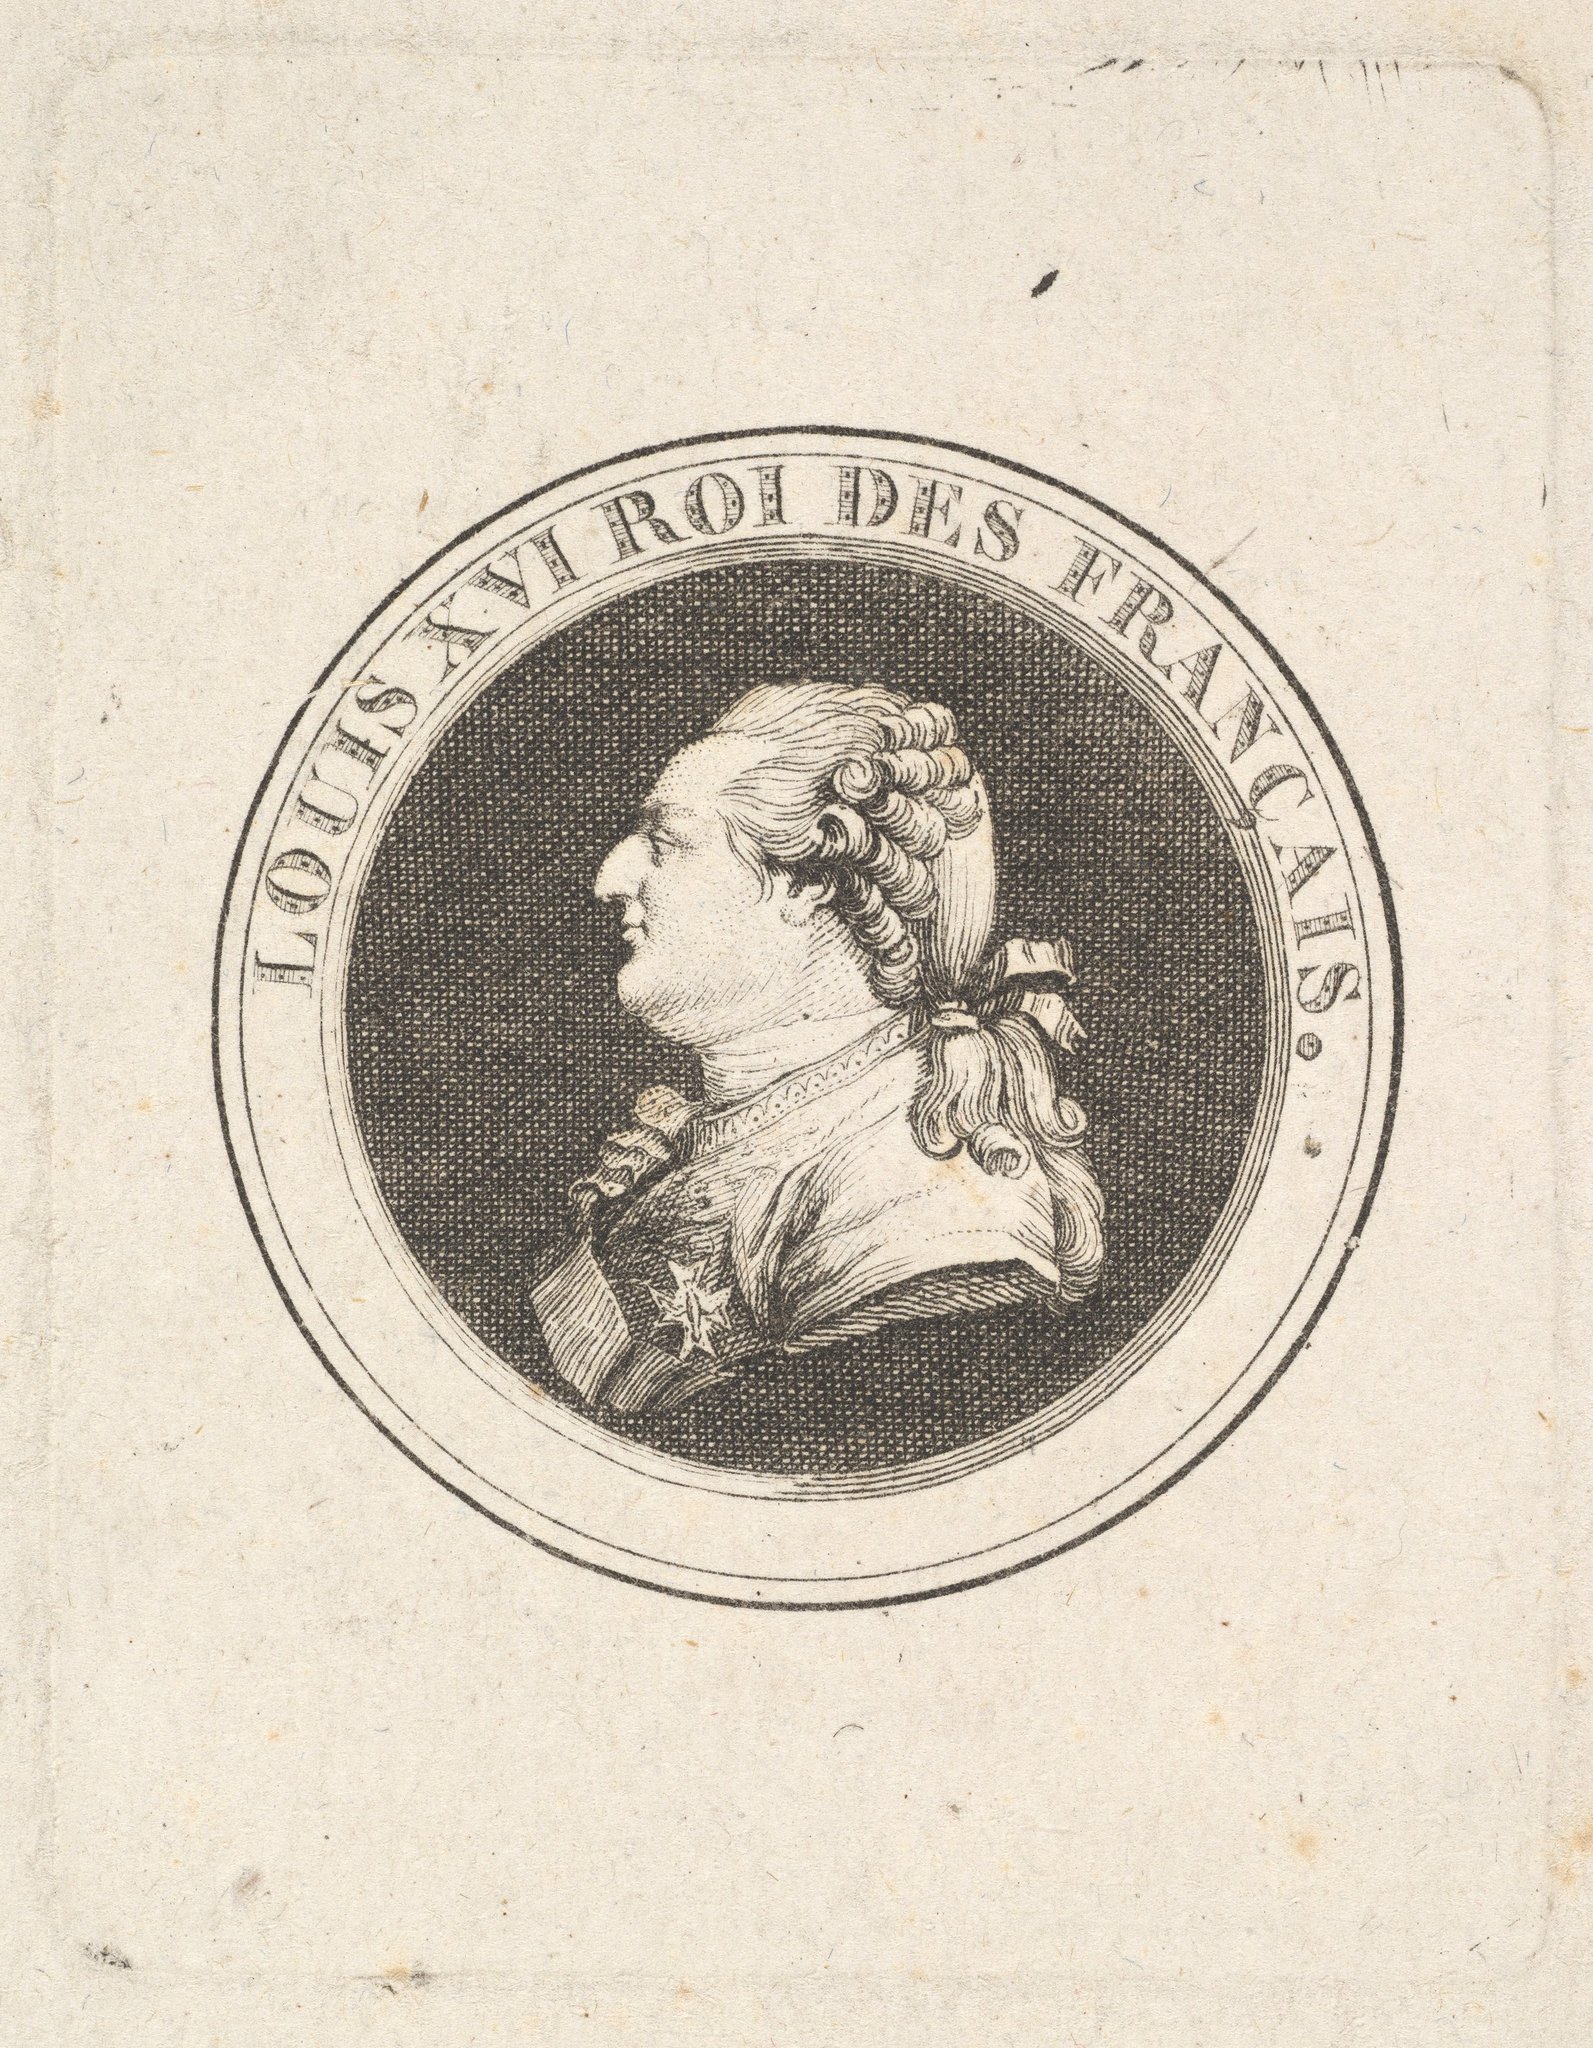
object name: print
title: Print of a Portrait Medal of Louis XVI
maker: augustin de saint-aubin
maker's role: artist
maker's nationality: french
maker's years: 1736-1807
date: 1789-1790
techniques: engraving, etching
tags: kings,louis xvi